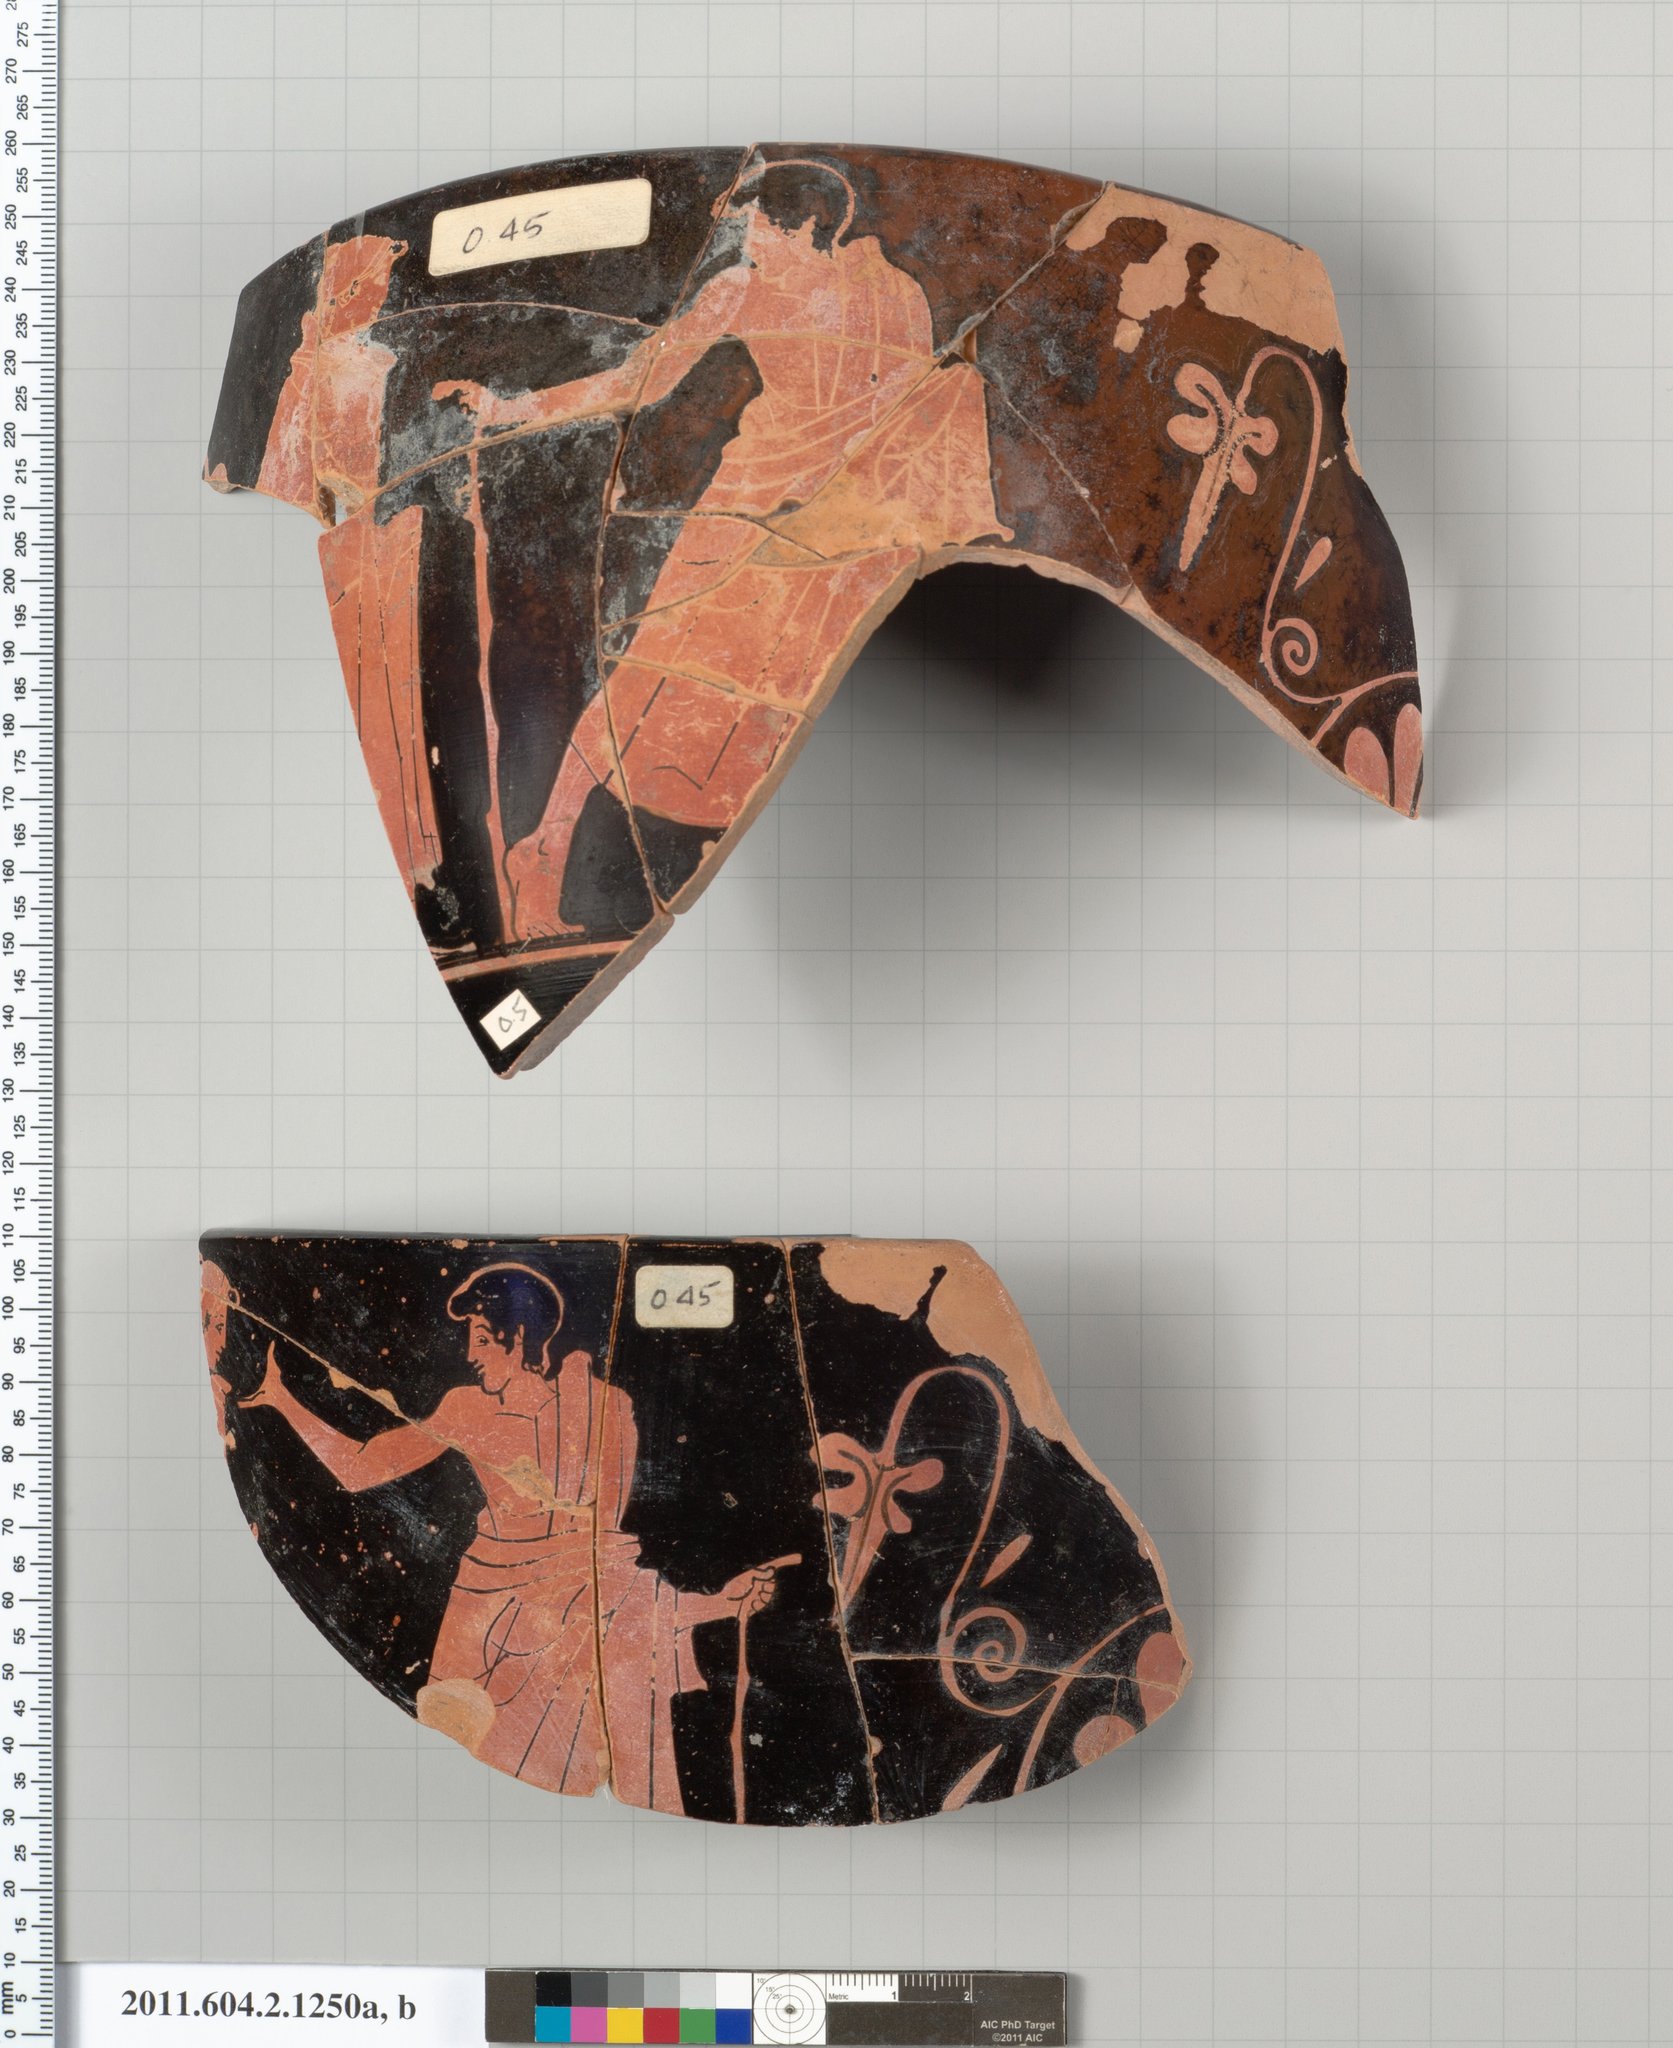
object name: skyphos fragment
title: Terracotta fragments of a skyphos (deep drinking cup)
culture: greek, attic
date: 467-435 BCE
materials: terracotta